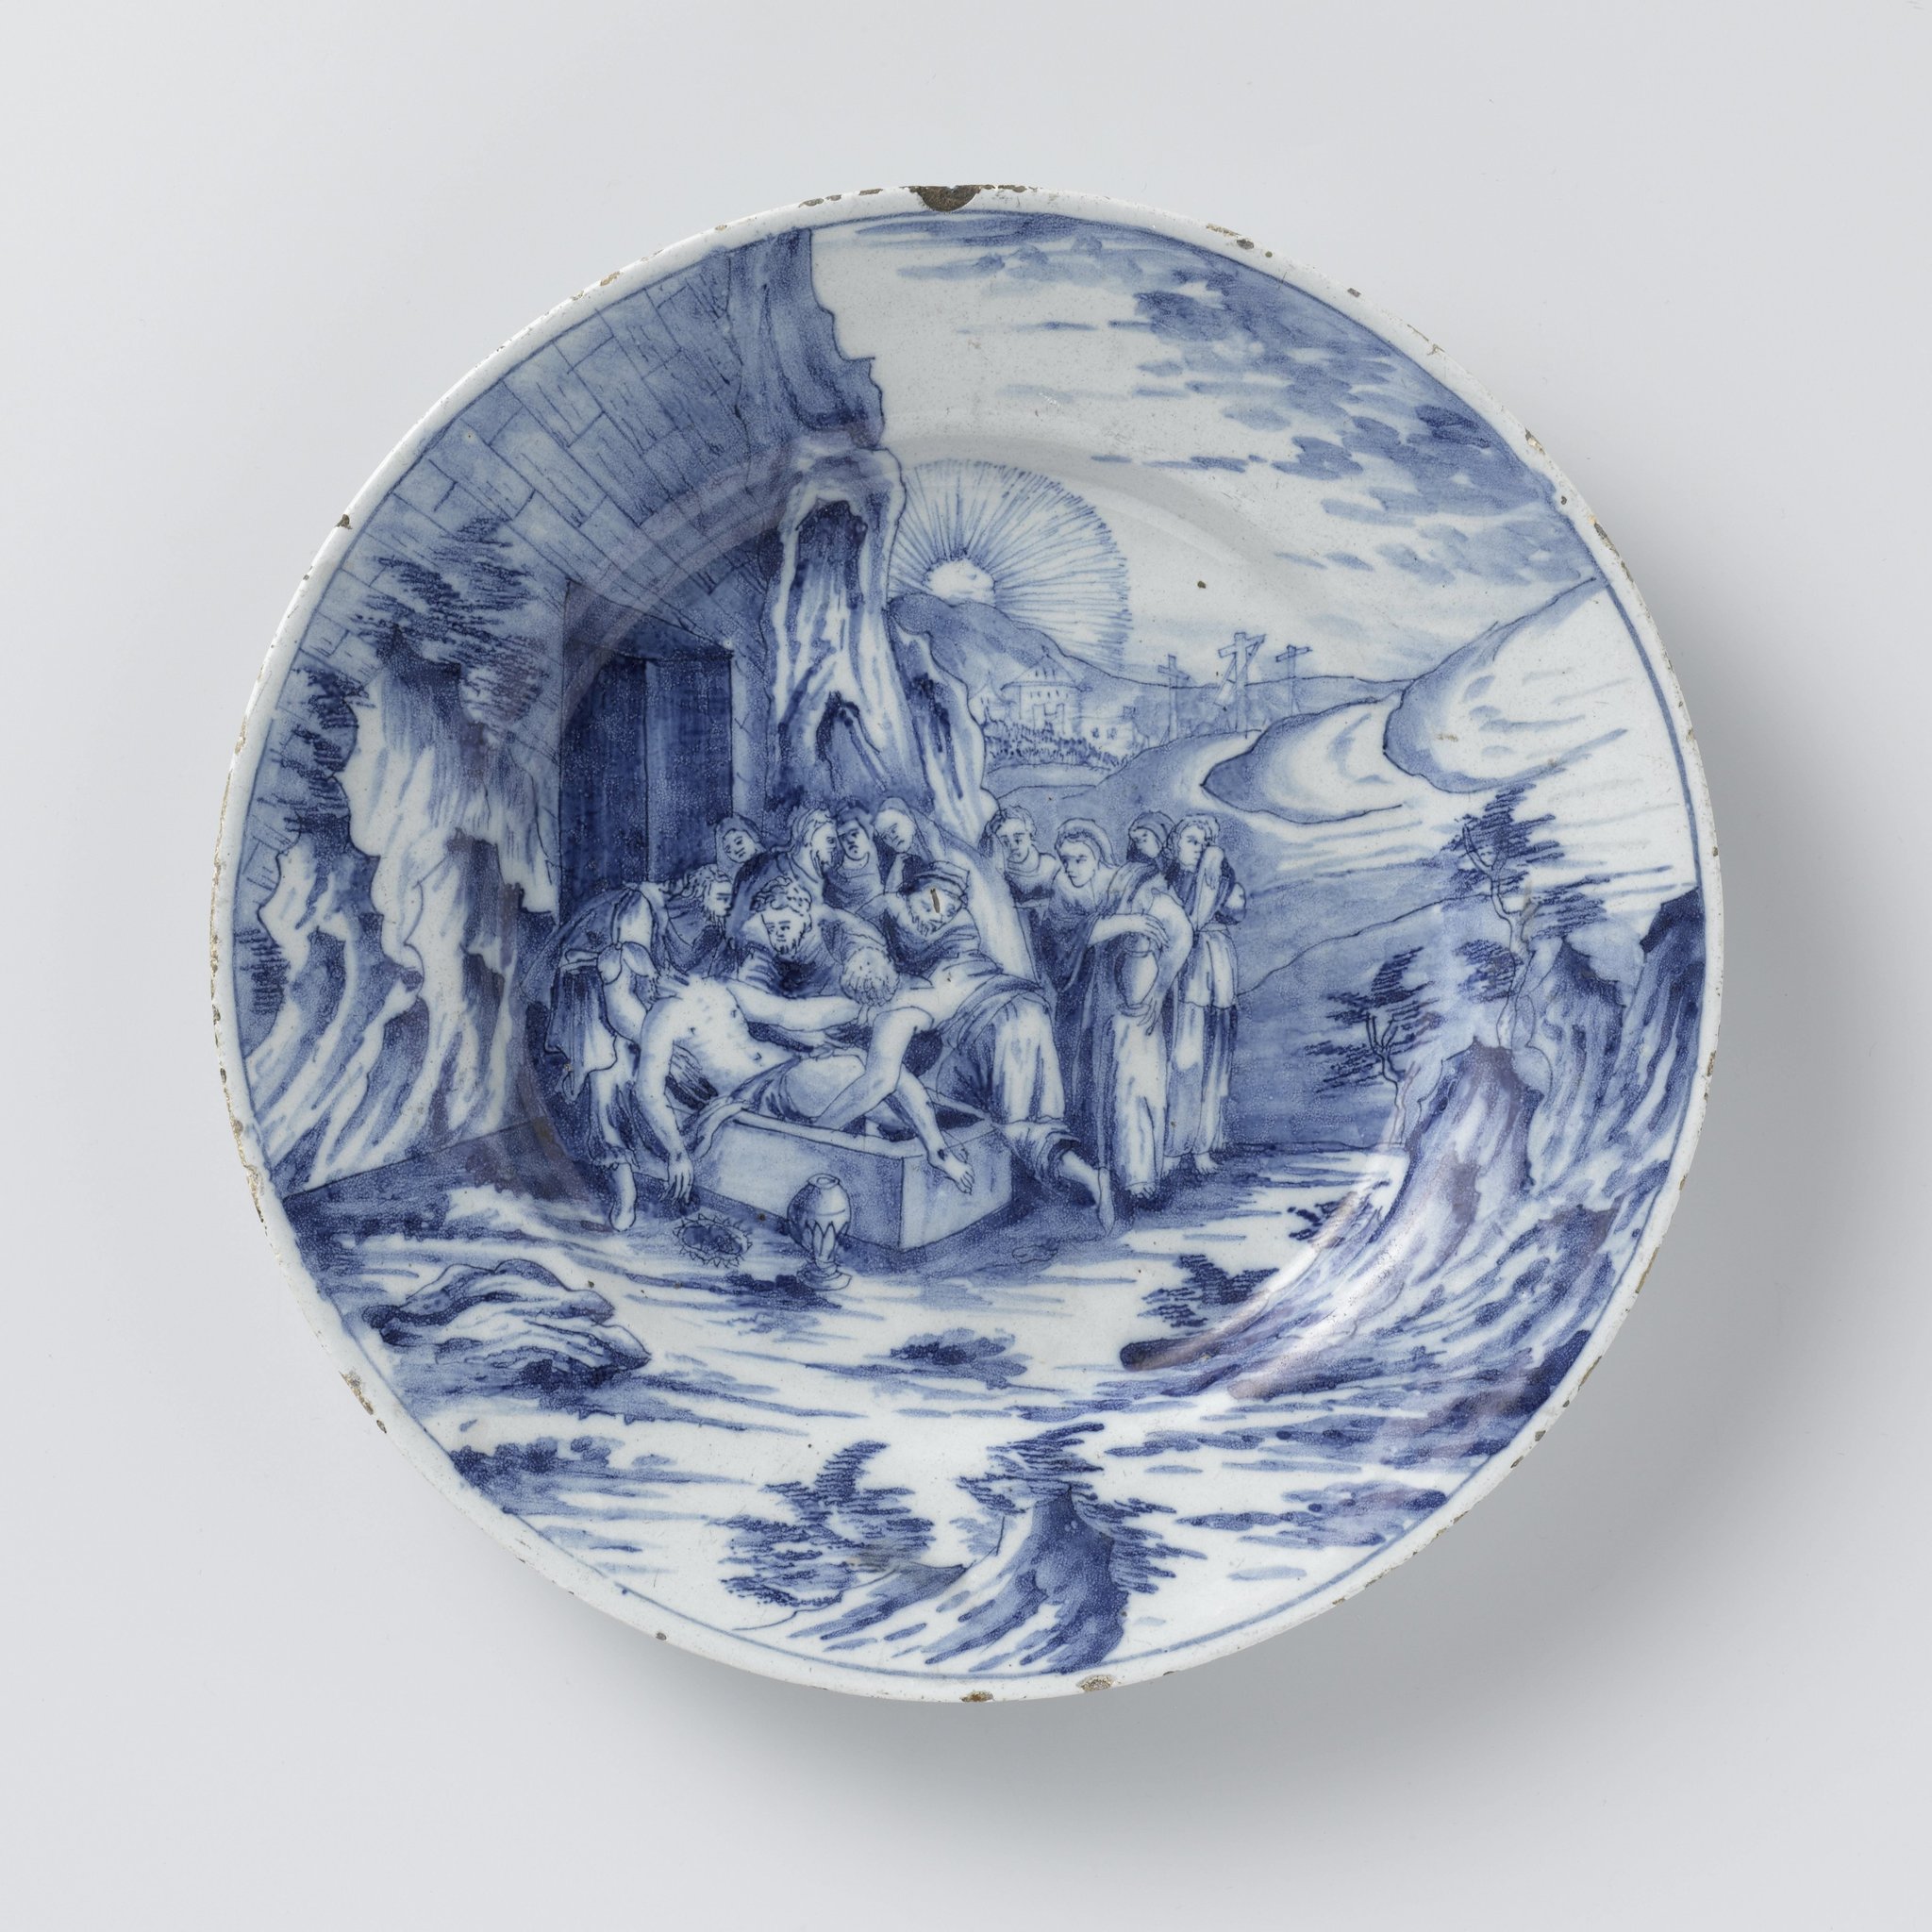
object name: plate dish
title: Bord van faïence met de graflegging van Christus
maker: Anonymous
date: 1750-1775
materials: faience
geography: delft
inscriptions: seal: ‘302’, collector's mark: ‘J. F. Loudon’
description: Bord van aardewerk, blauw beschilderd op tinglazuur met de graflegging van Christus over het gehele oppervlak beschilderd.